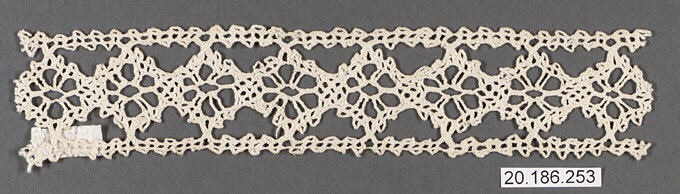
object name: insertion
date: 1501-1600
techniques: lace